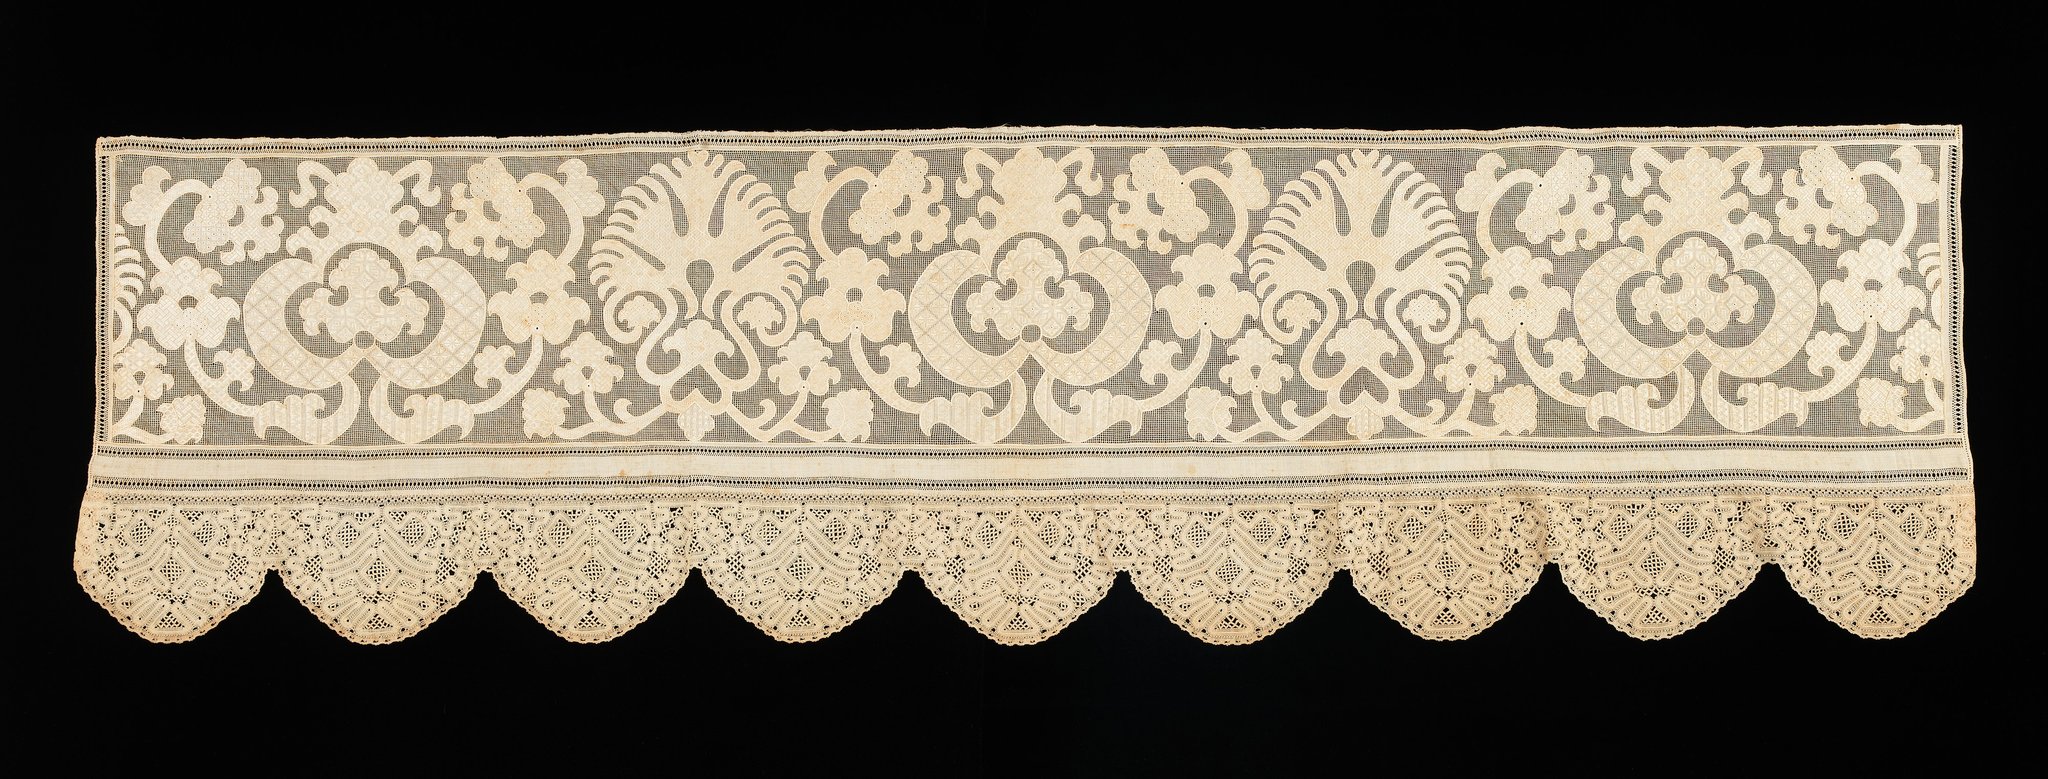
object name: border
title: Bed curtain border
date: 1776-1800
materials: linen